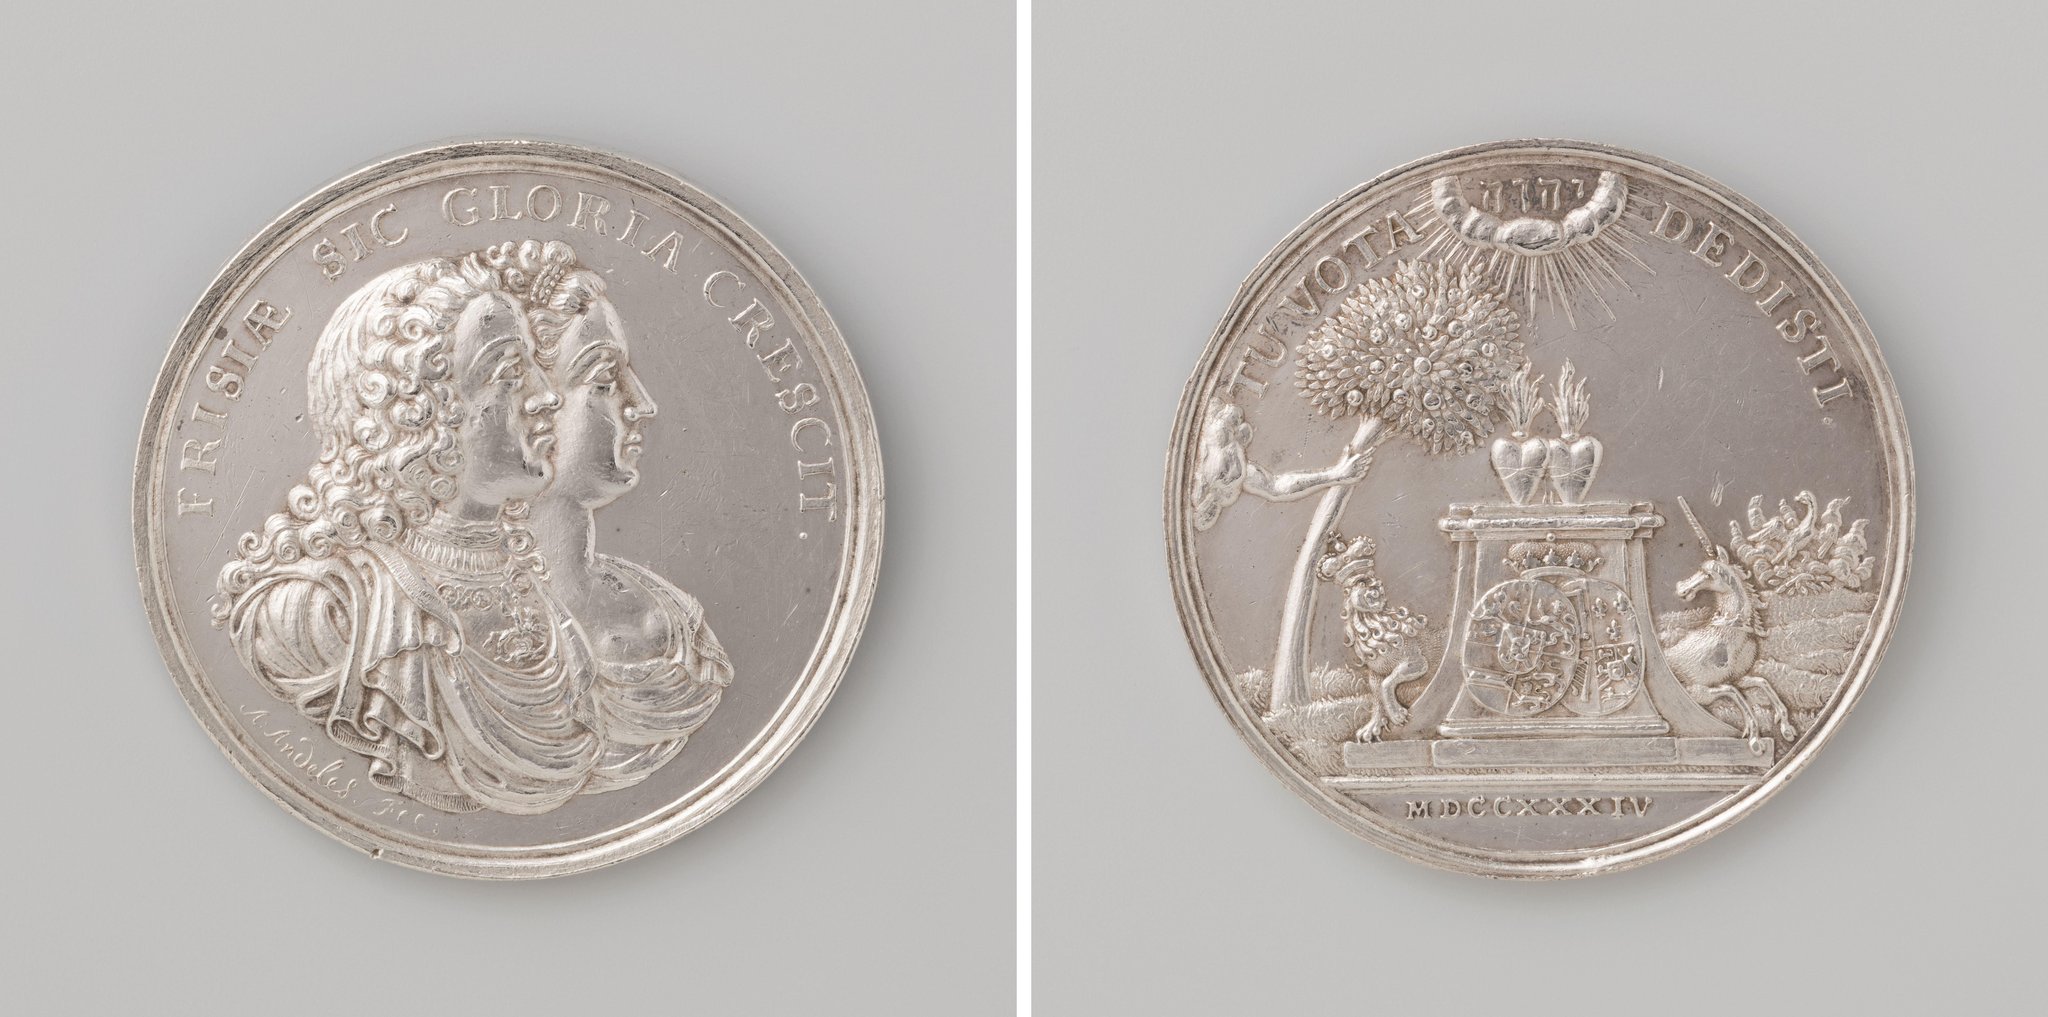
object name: history medal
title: Huwelijk van Willem IV met prinses Anna van Engeland te Londen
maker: andele andeles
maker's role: medailleur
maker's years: 1687-1754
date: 1734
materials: silver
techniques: striking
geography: leeuwarden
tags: the hague, willem iv (prins van oranje-nassau), anna van hannover, london